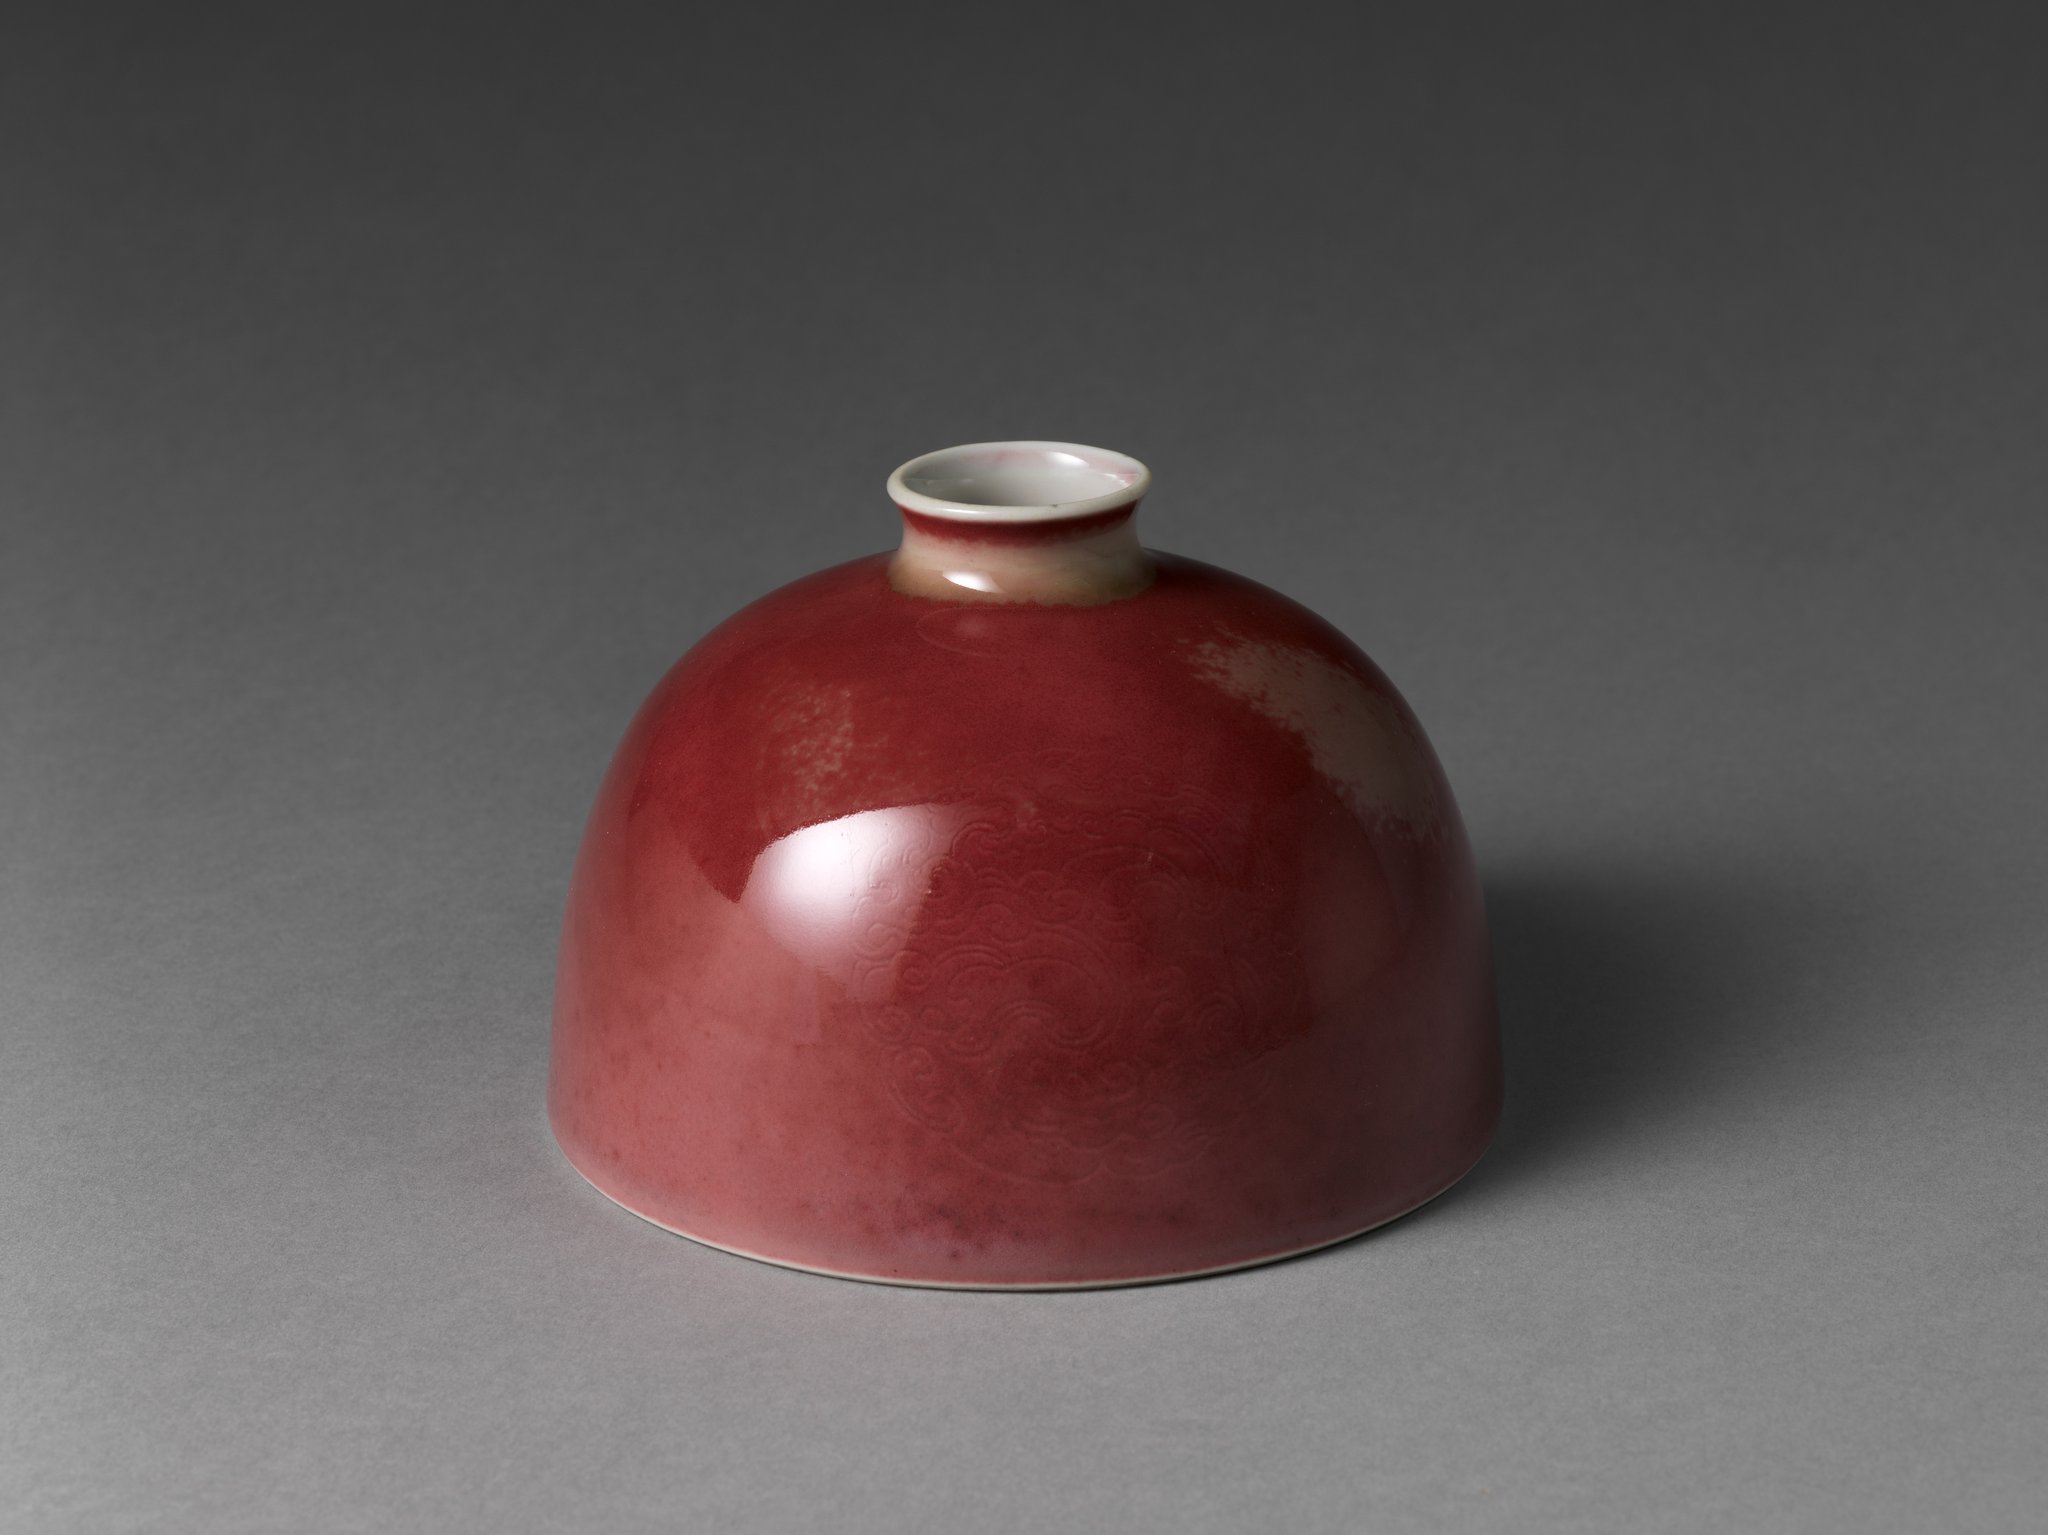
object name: jar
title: Water Jar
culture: chinese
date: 1678-1688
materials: glaze, porcelain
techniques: incising